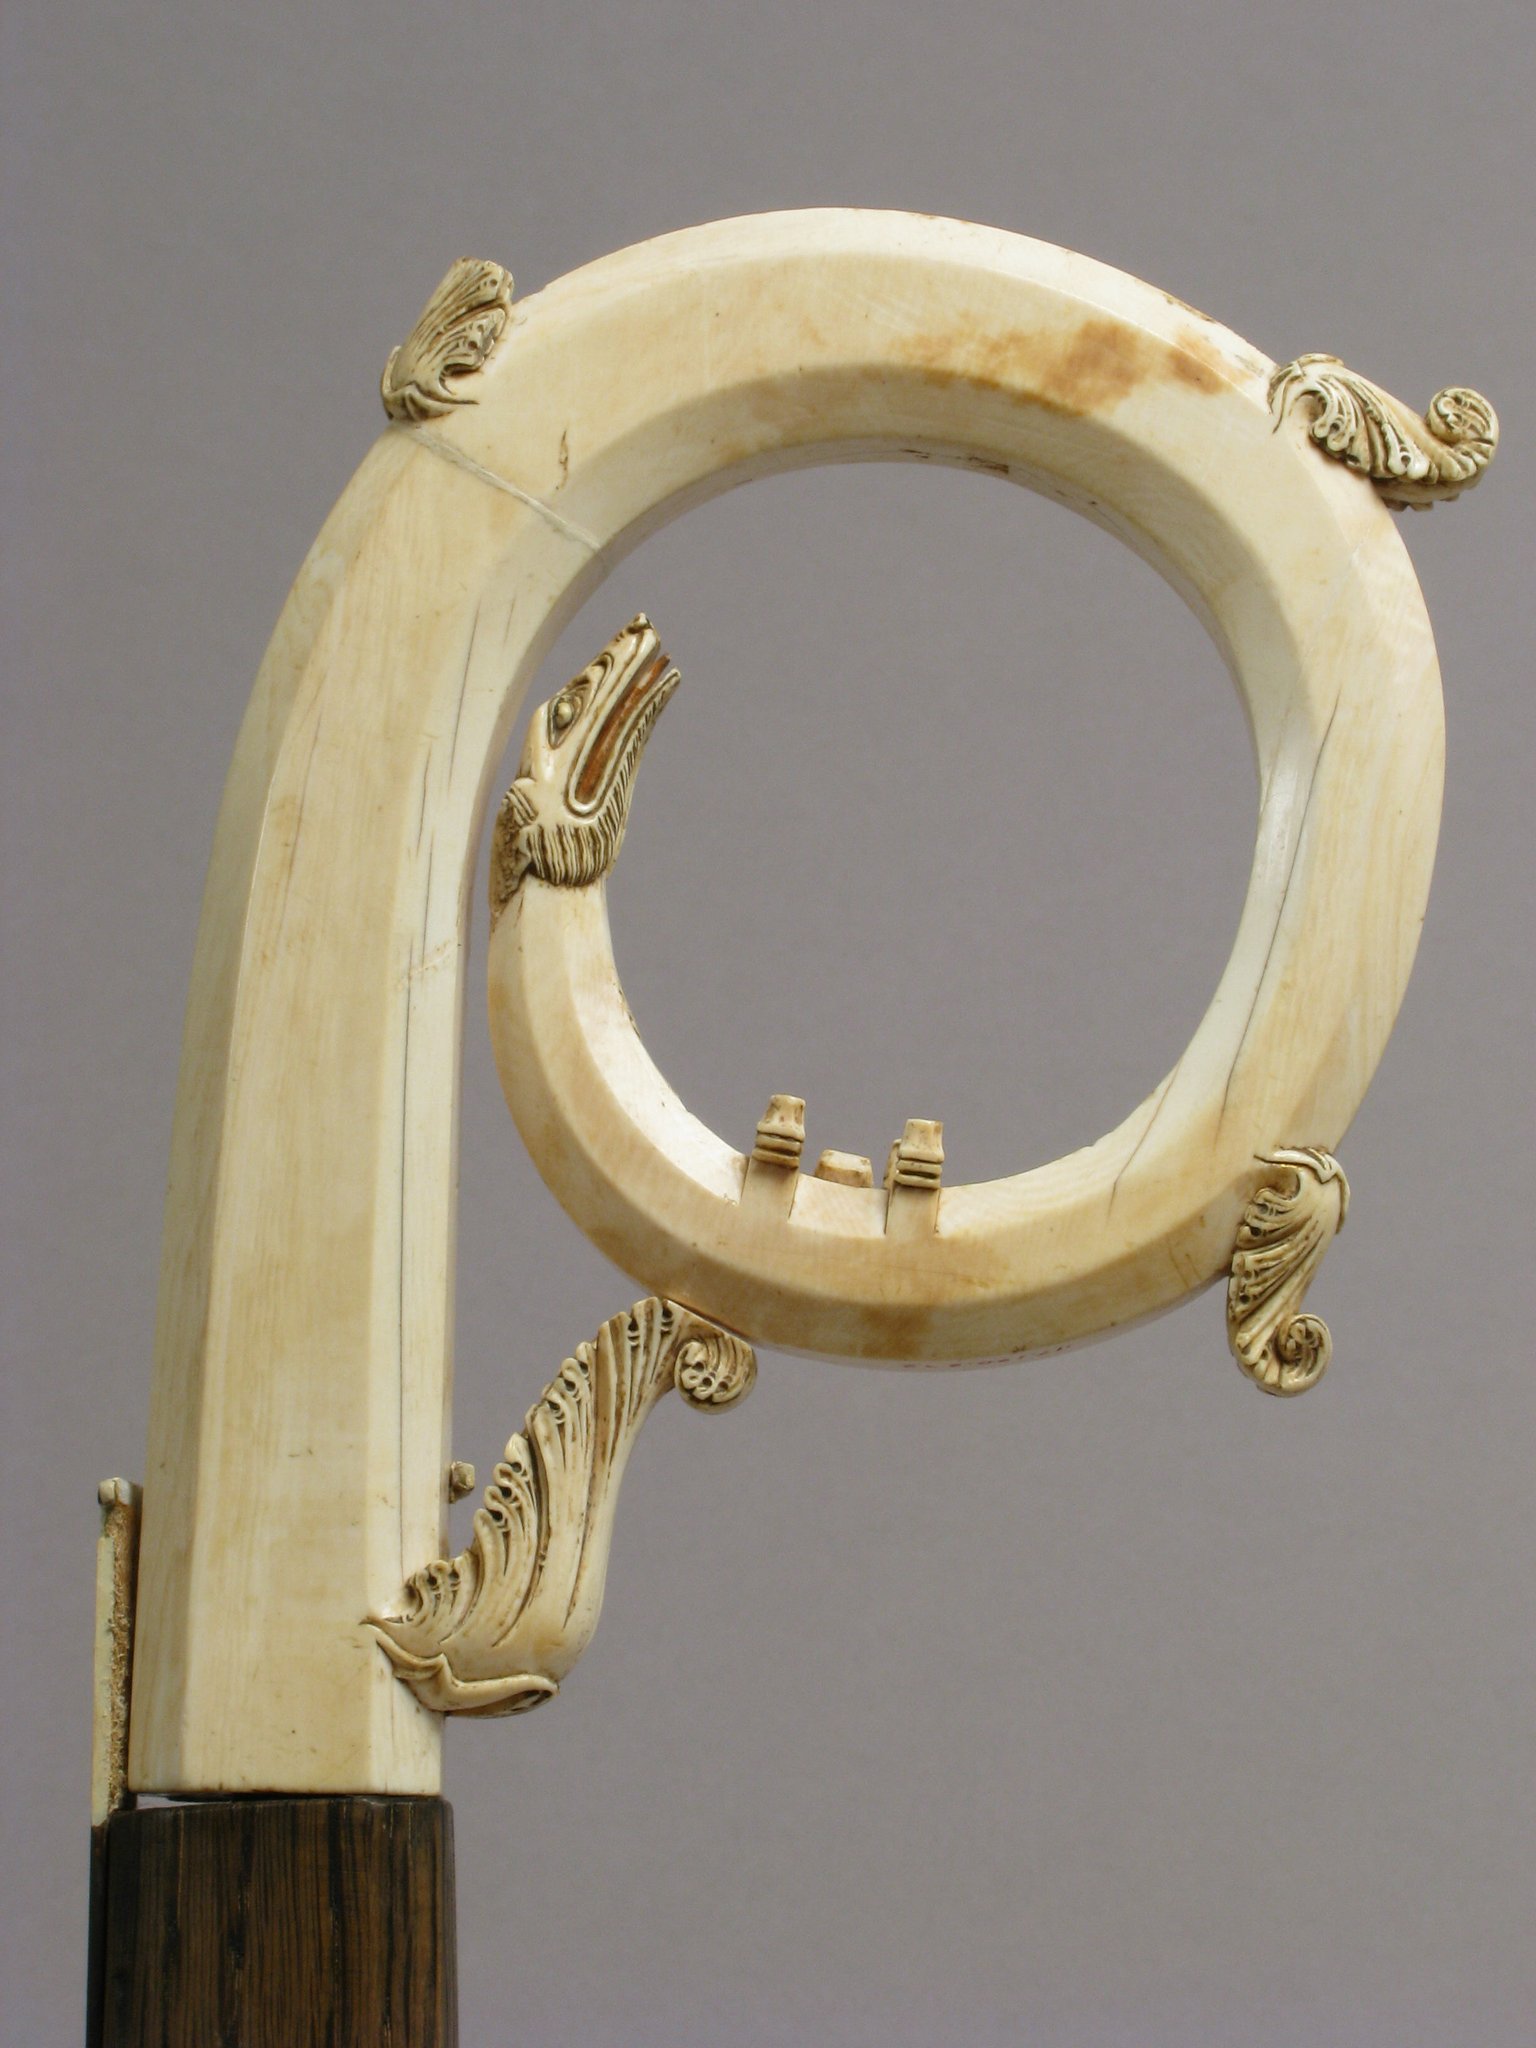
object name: crozier head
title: Head of a Crozier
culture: south italian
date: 1175-1225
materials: ivory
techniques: gilding, polychromy